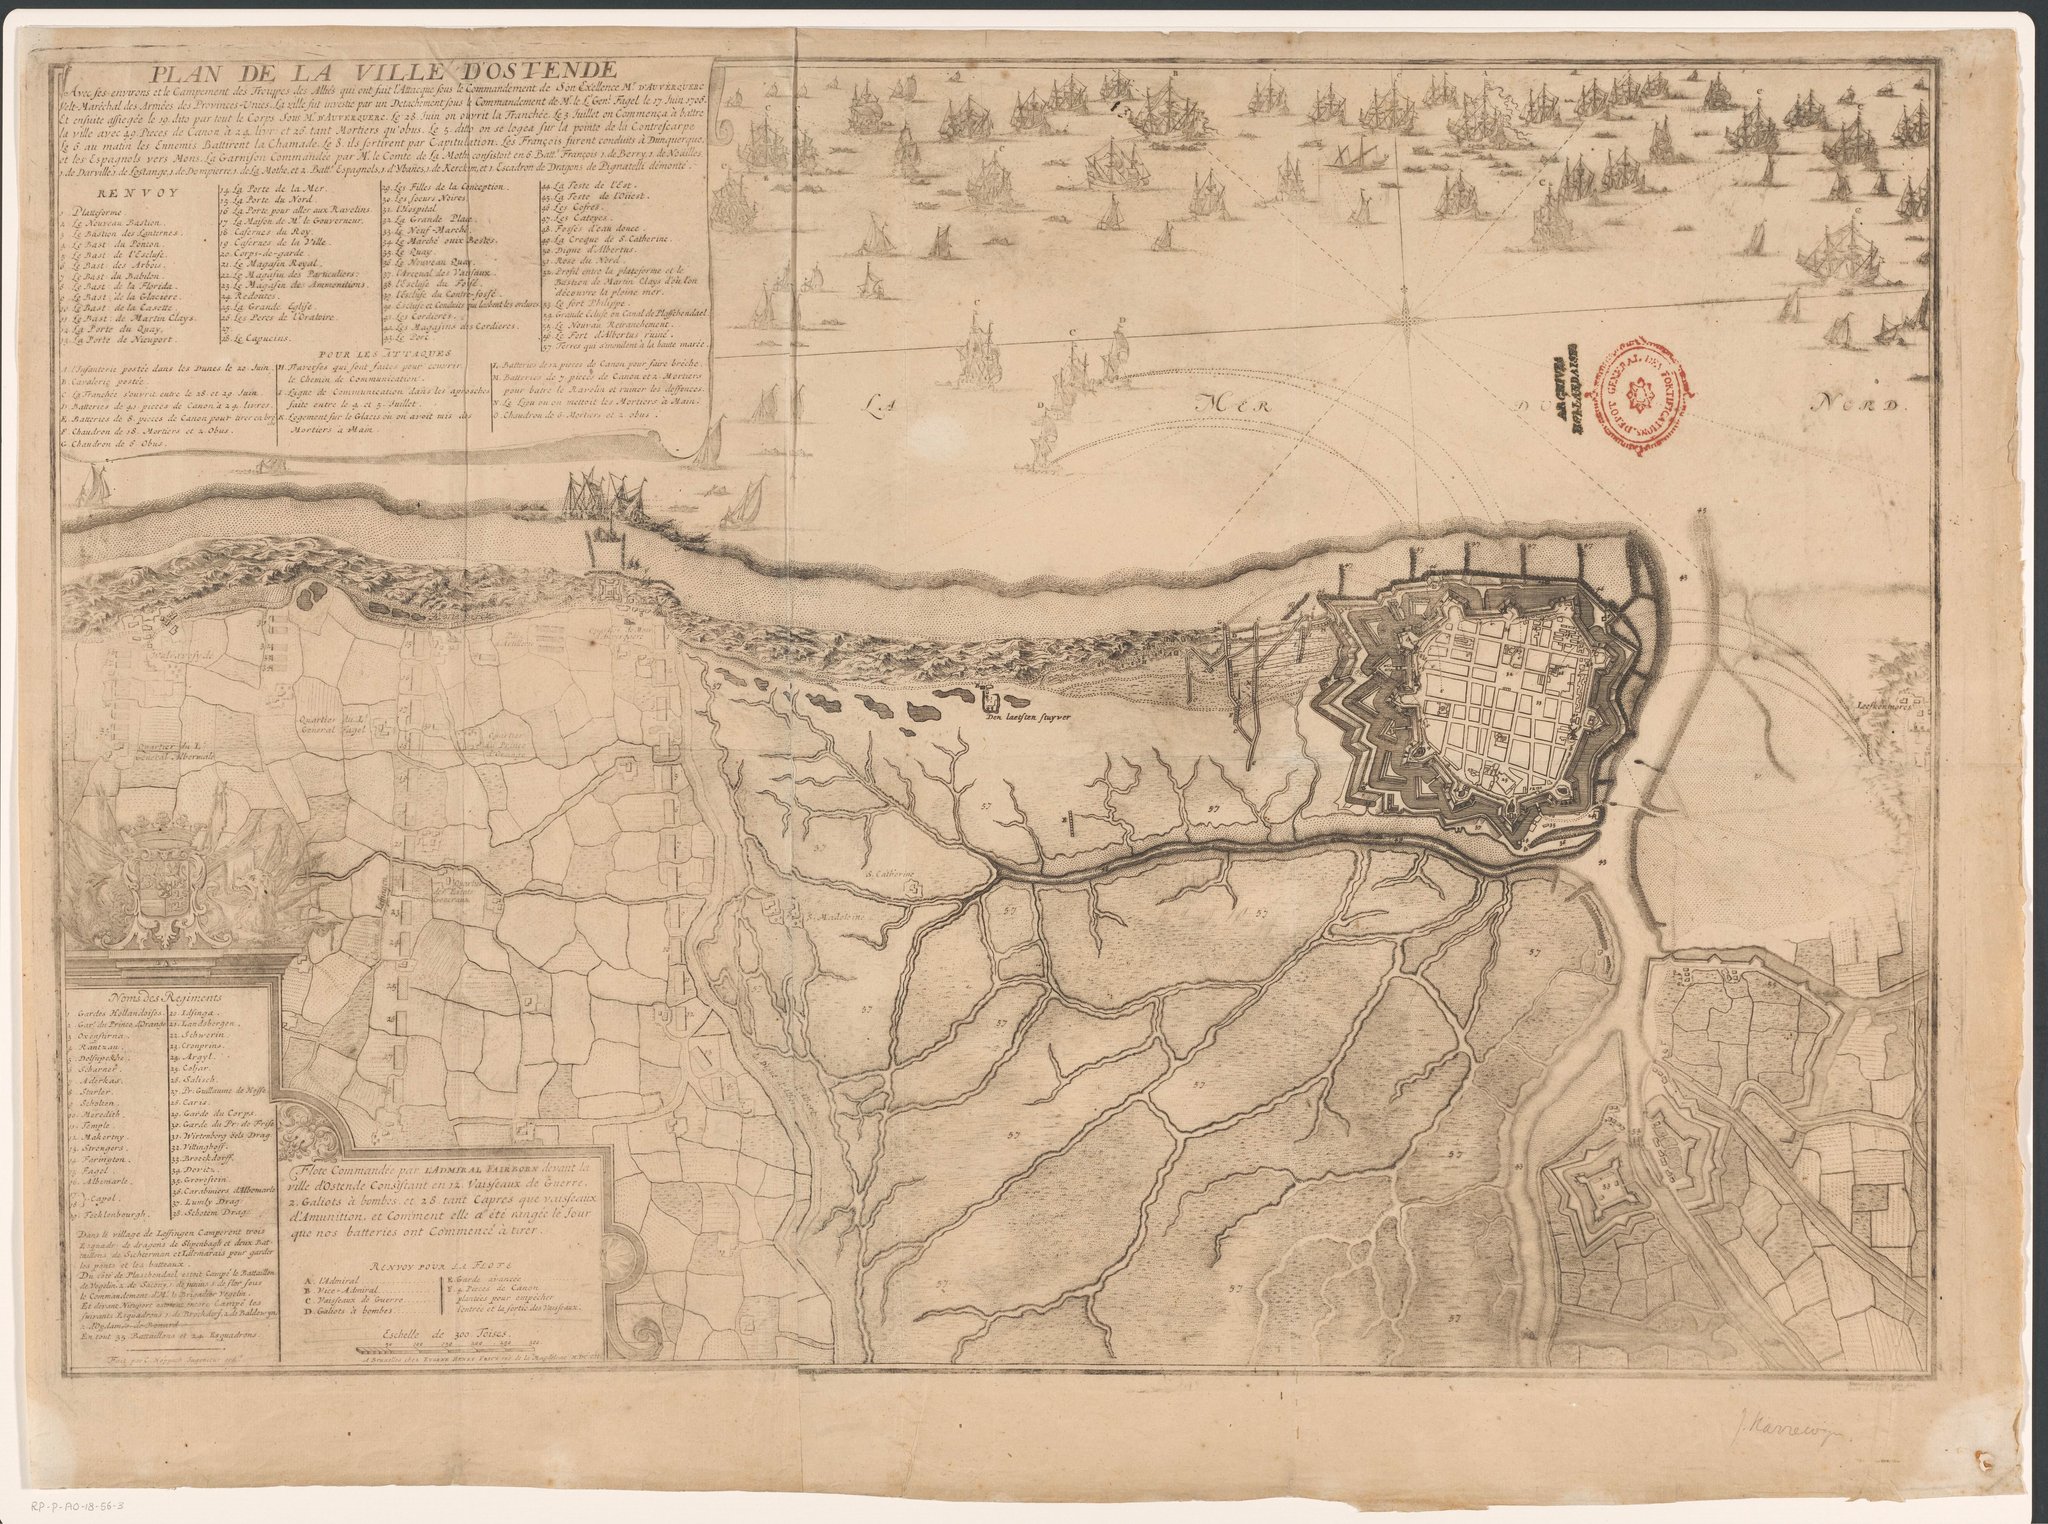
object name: map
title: Plan de la ville d'Ostende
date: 1707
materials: paper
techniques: etching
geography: brussels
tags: françois nicolaas fagel, the hague, maps of separate countries or regions, siege, position war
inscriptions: collector's mark: ‘Archives Hollandaises’, collector's mark: ‘Depot General des Fortifications’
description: Kaart van het beleg van Oostende door de Geallieerden onder Hendrik van Nassau, heer van Ouwerkerk, belegerd vanaf 17 juni, ingenomen op 6 juli 1706. Linksboven een cartouche met de titel en de legenda 1-57 in het Frans. Linksonder een cartouche met een lijst van de regimenten die deel namen aan de belegering met bovenin het wapen van Hendrik van Nassau, heer van Ouwekerk en rechtsonderin een schaalstok: Eschelle de 300 Toises.